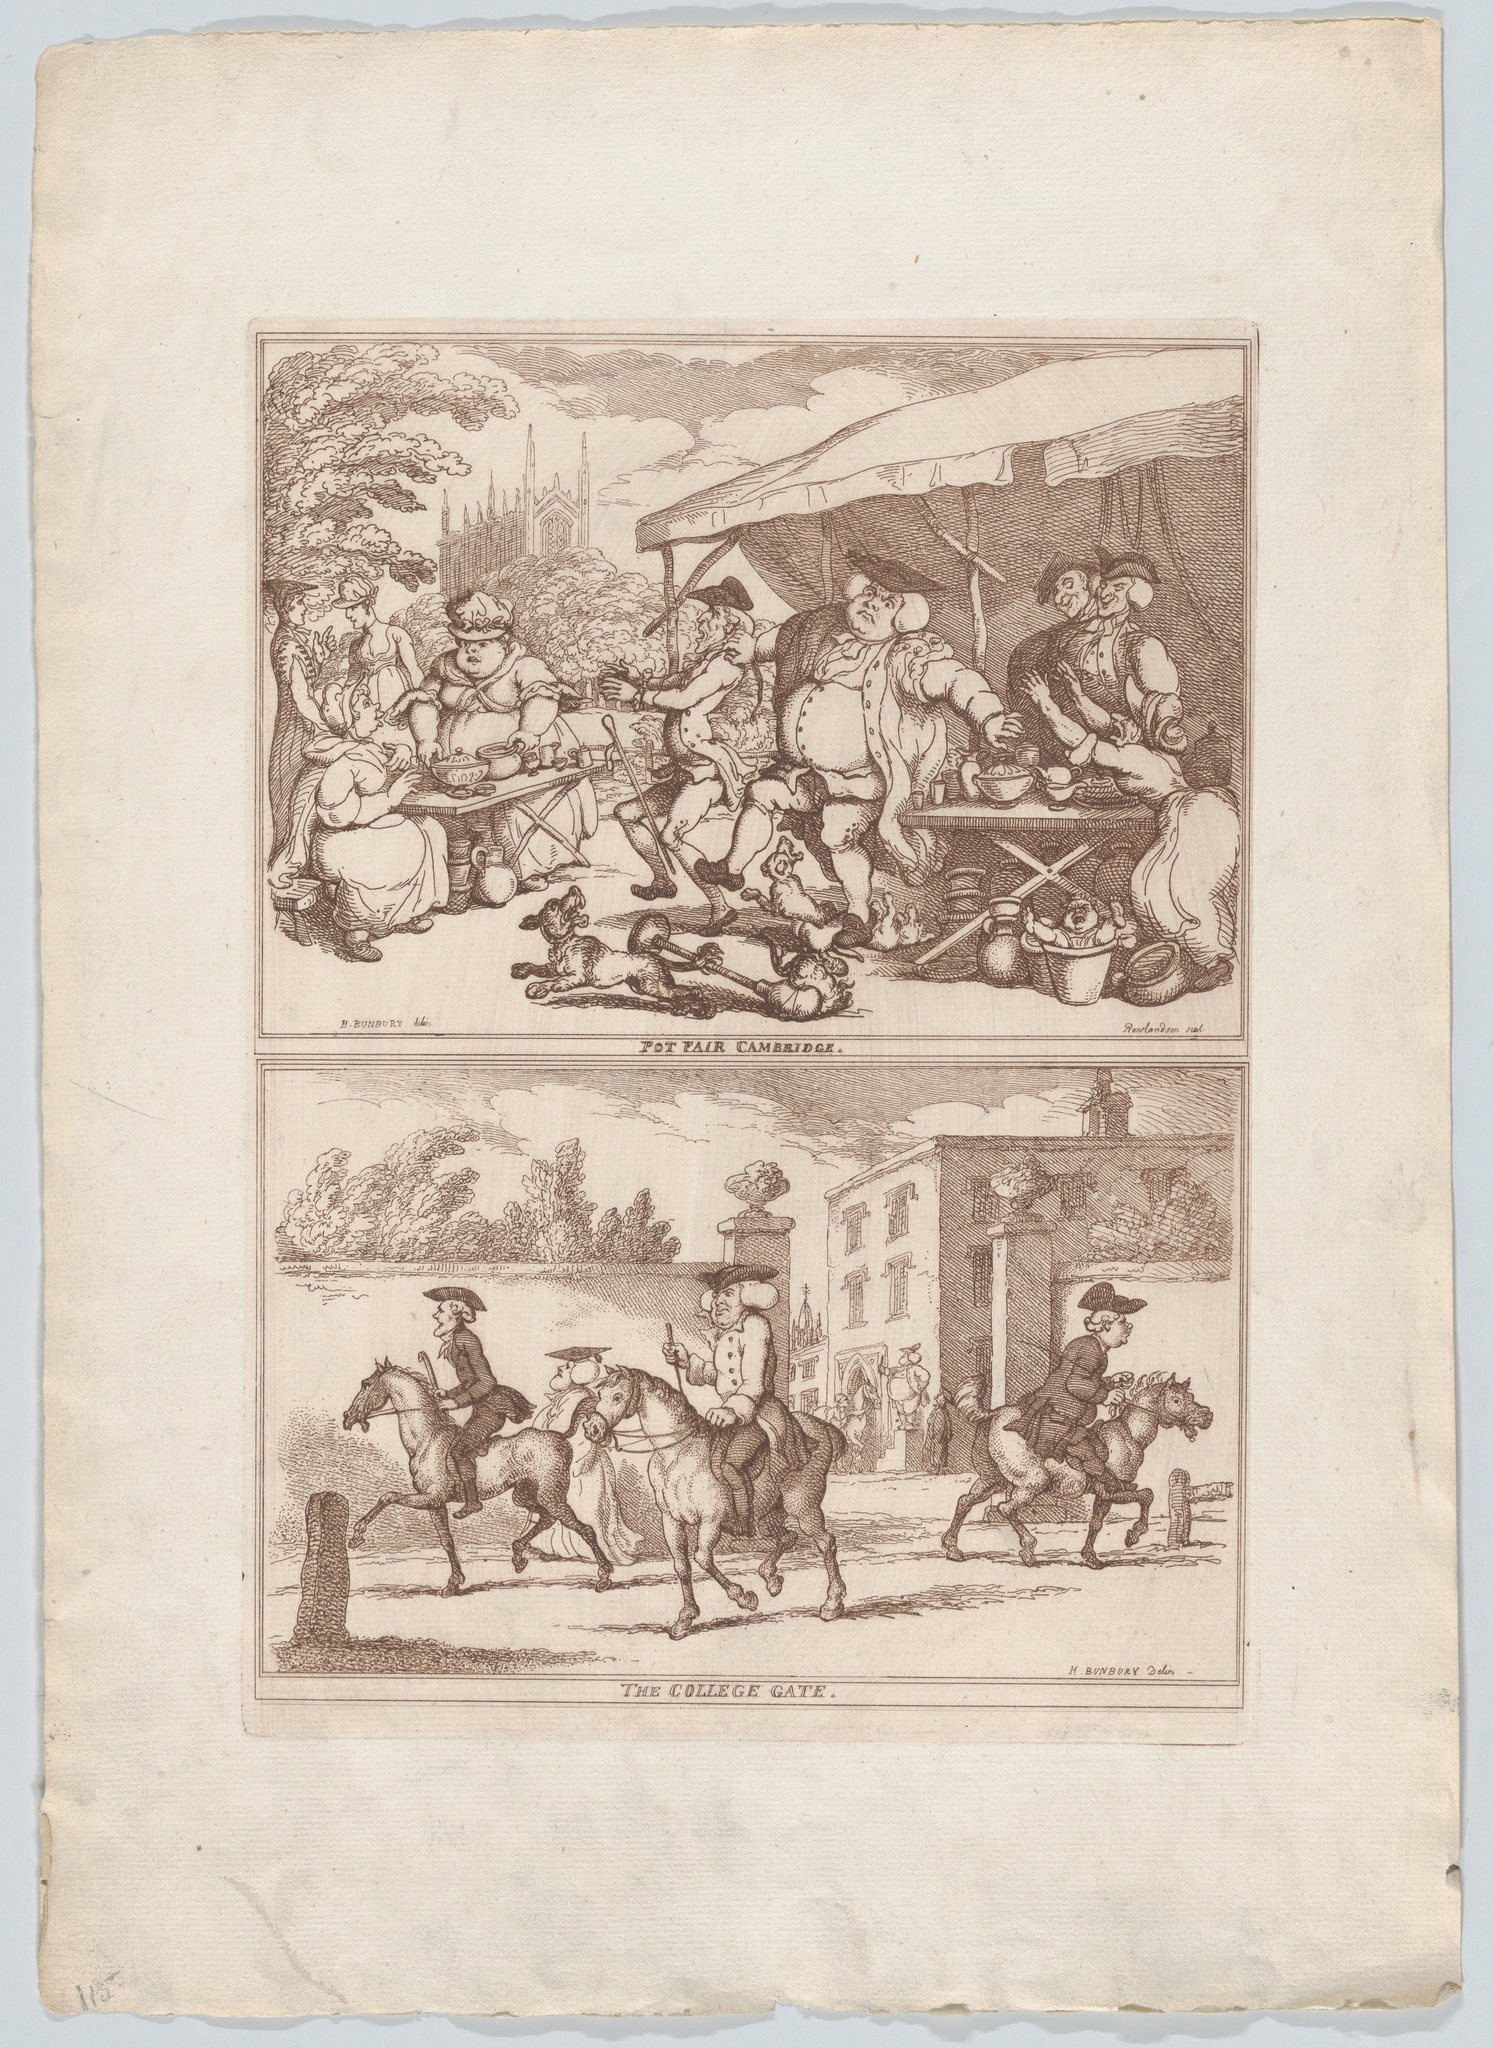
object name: print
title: Pot Fair Cambridge, and, The College Gate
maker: thomas rowlandson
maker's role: artist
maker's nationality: british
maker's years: 1757-1827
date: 1780-1790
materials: ink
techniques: etching, printing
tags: satire,men,women,dogs,horses